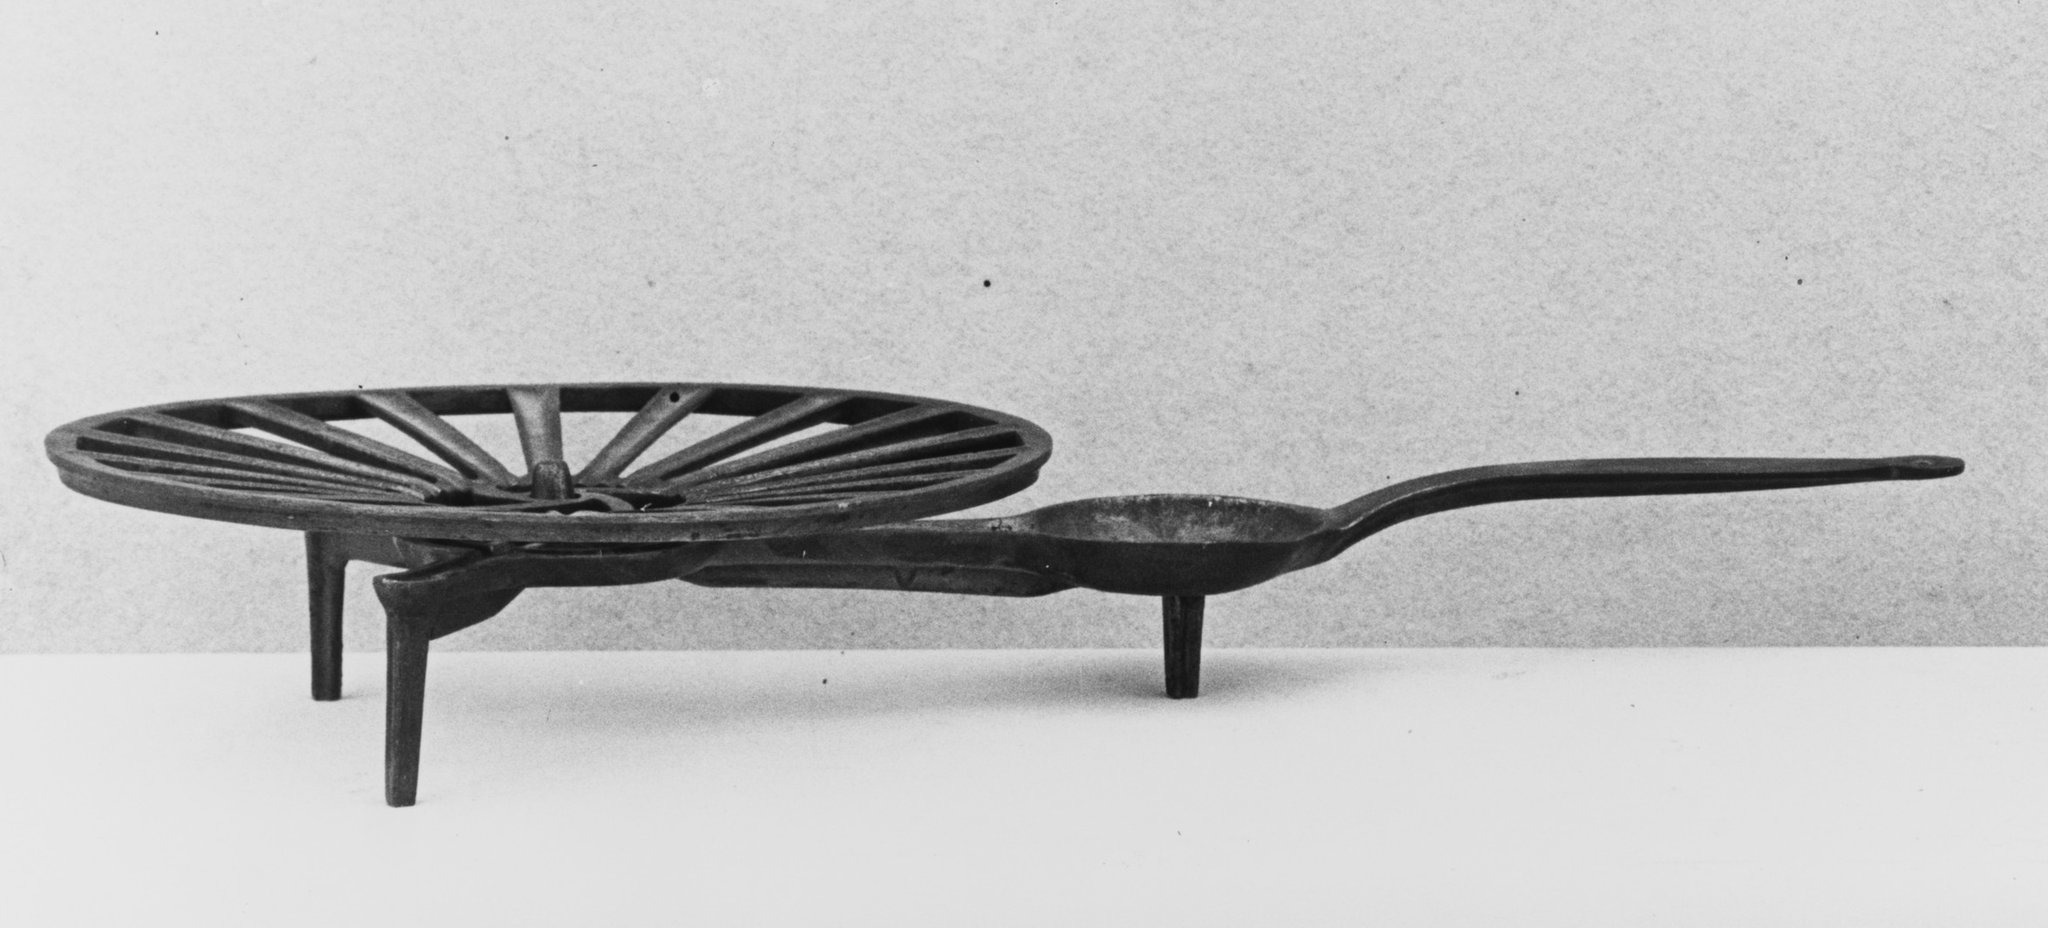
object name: gridiron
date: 1700-1800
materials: iron